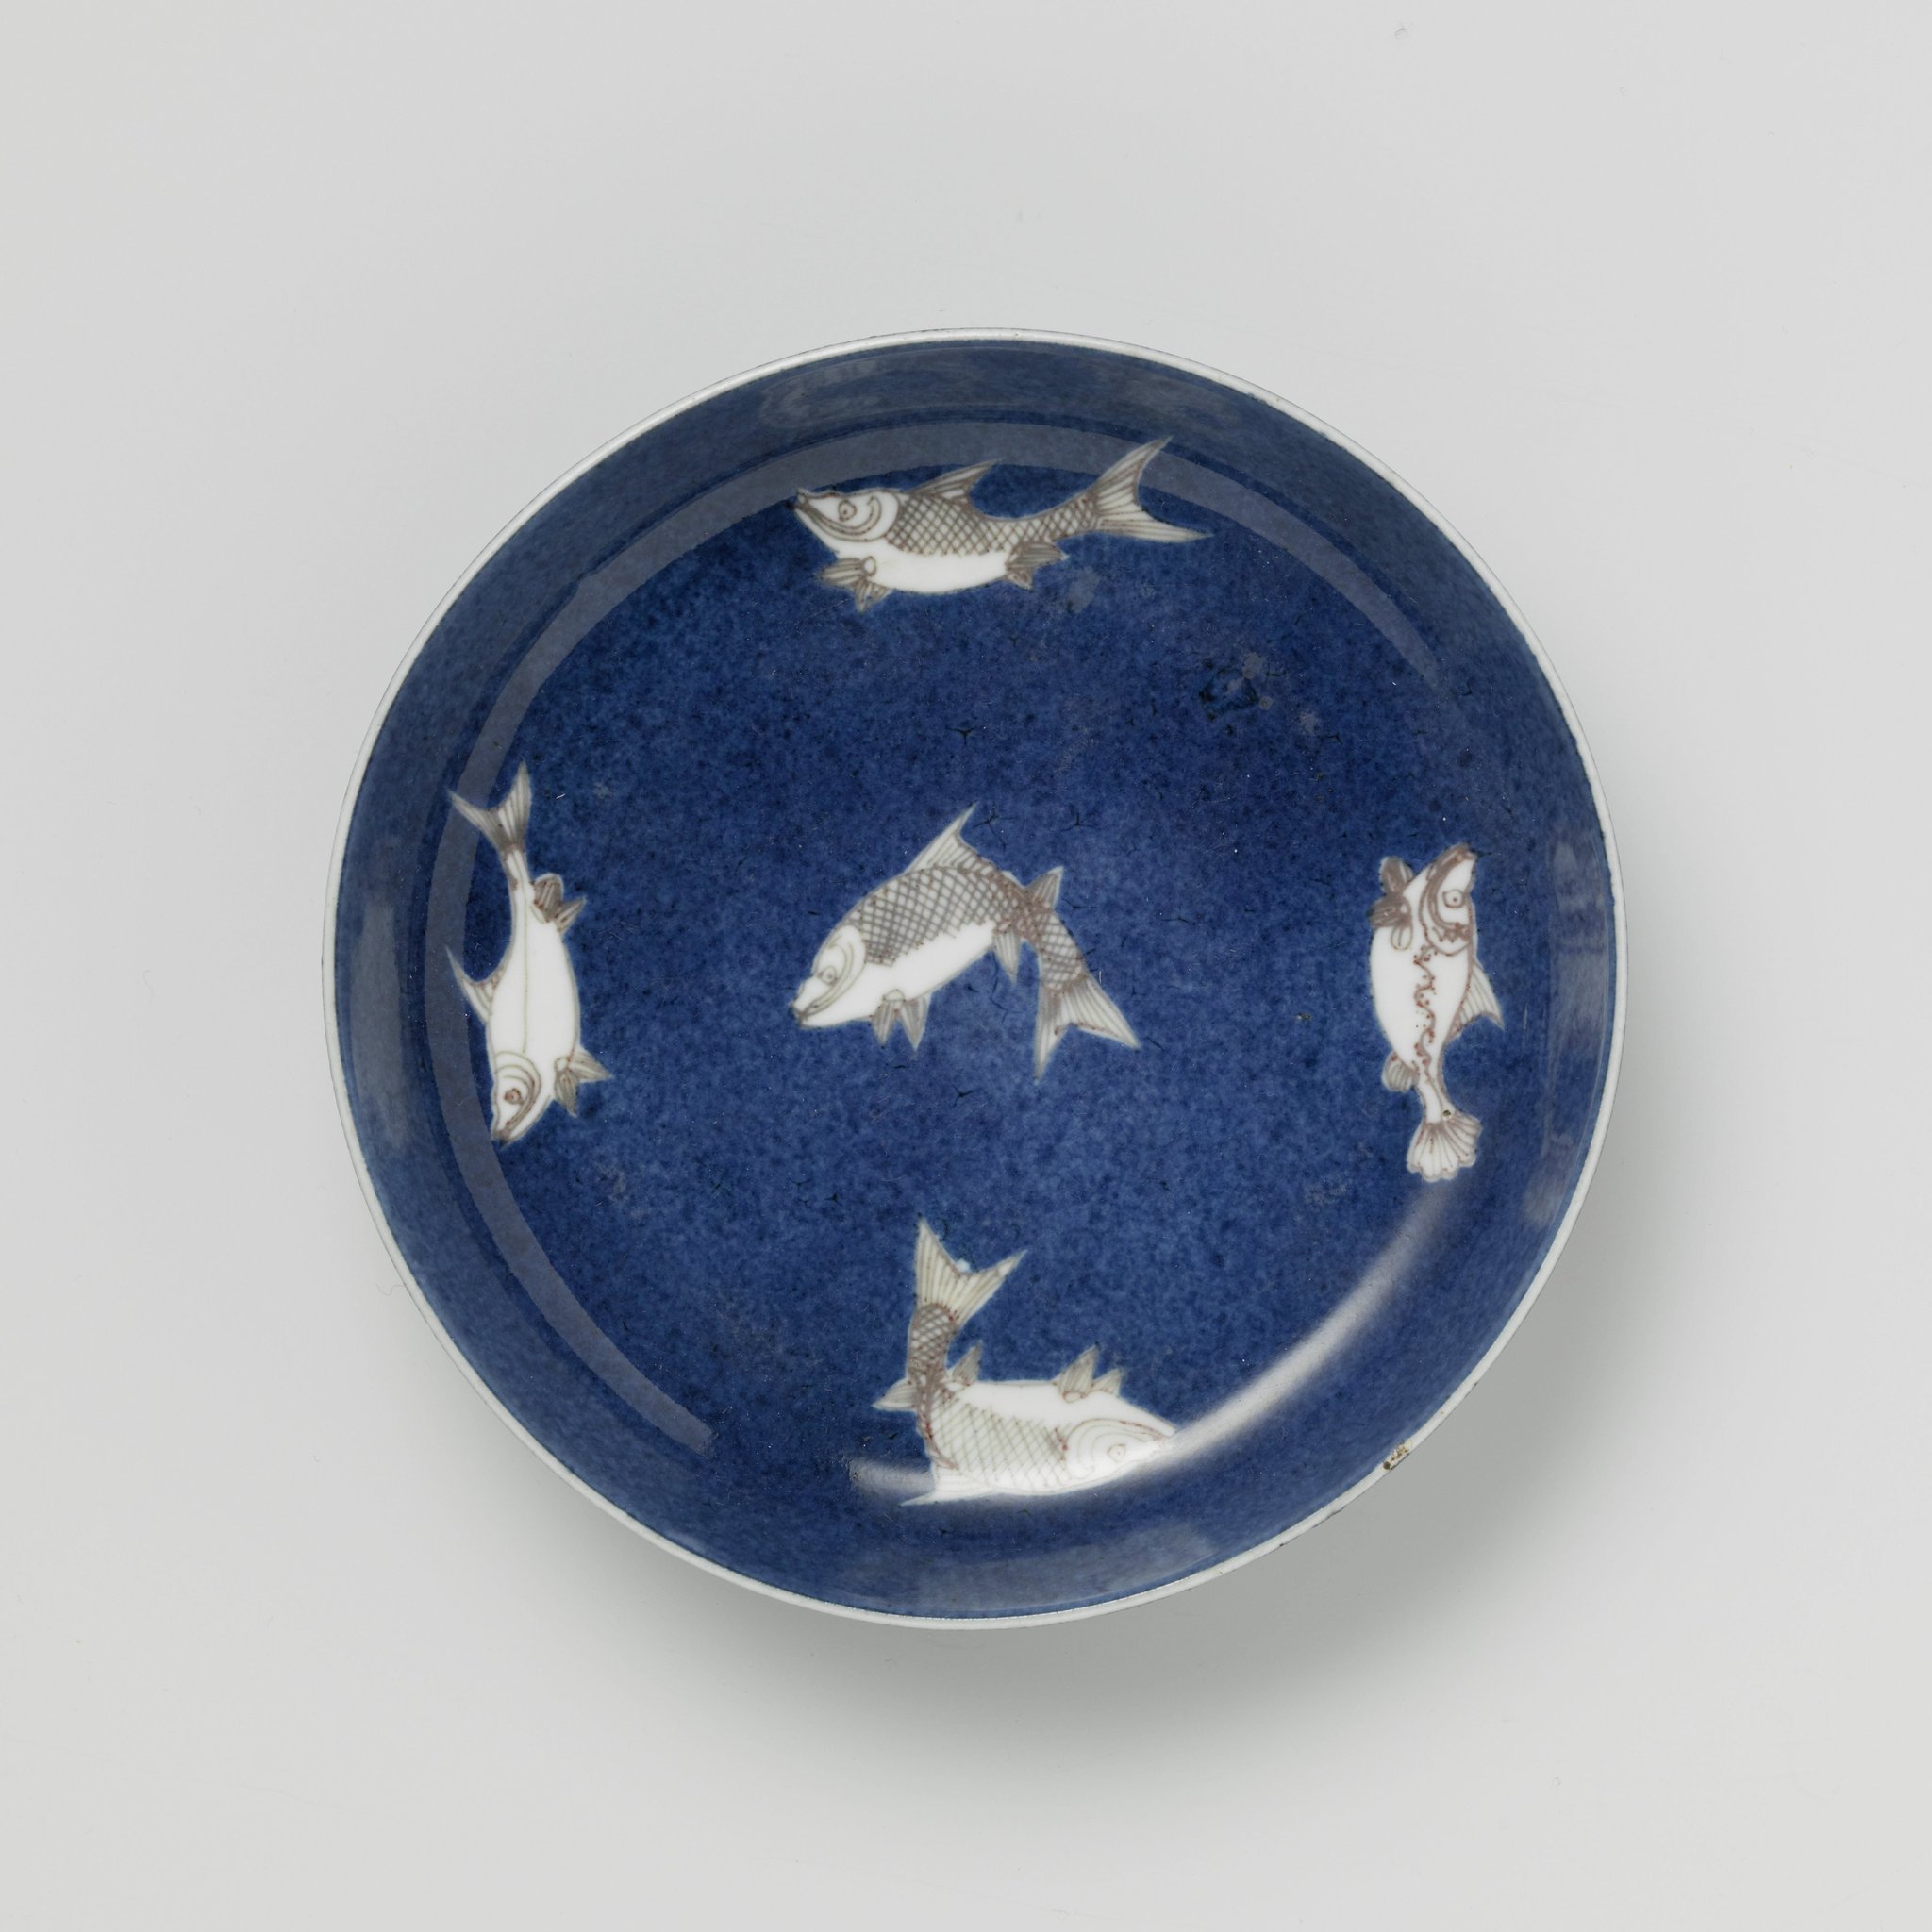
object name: dish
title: Saucer-dish with powder blue and fish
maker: Anonymous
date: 1700-1724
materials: cobalt, copper, glaze, paint, porcelain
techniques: firing, turning, vitrification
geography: china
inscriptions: label: ‘Vrienden der Aziatische Kunst / R. May’, mark: ‘亞’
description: Schaal met ronde wand van porselein, beschilderd met onderglazuur blauw en rood. De voorzijde is bedekt met bleu poudré (poederblauw) met hierin uitgespaard vijf vissen; de achterzijde van de wand is ook bedekt met poederblauw. Gemerkt op de onderzijde met het Fú symbool, een van de Twaalf Antieke Ornamenten, in een dubbele cirkel. Een chip in de rand. Oud label op de onderzijde met 'Vrienden der Aziatische Kunst / R. May'. Onderglazuur blauw met koperrood.